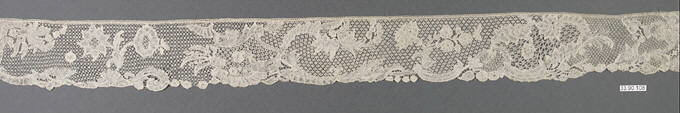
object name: edging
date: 1734-1766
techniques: lace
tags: flowers